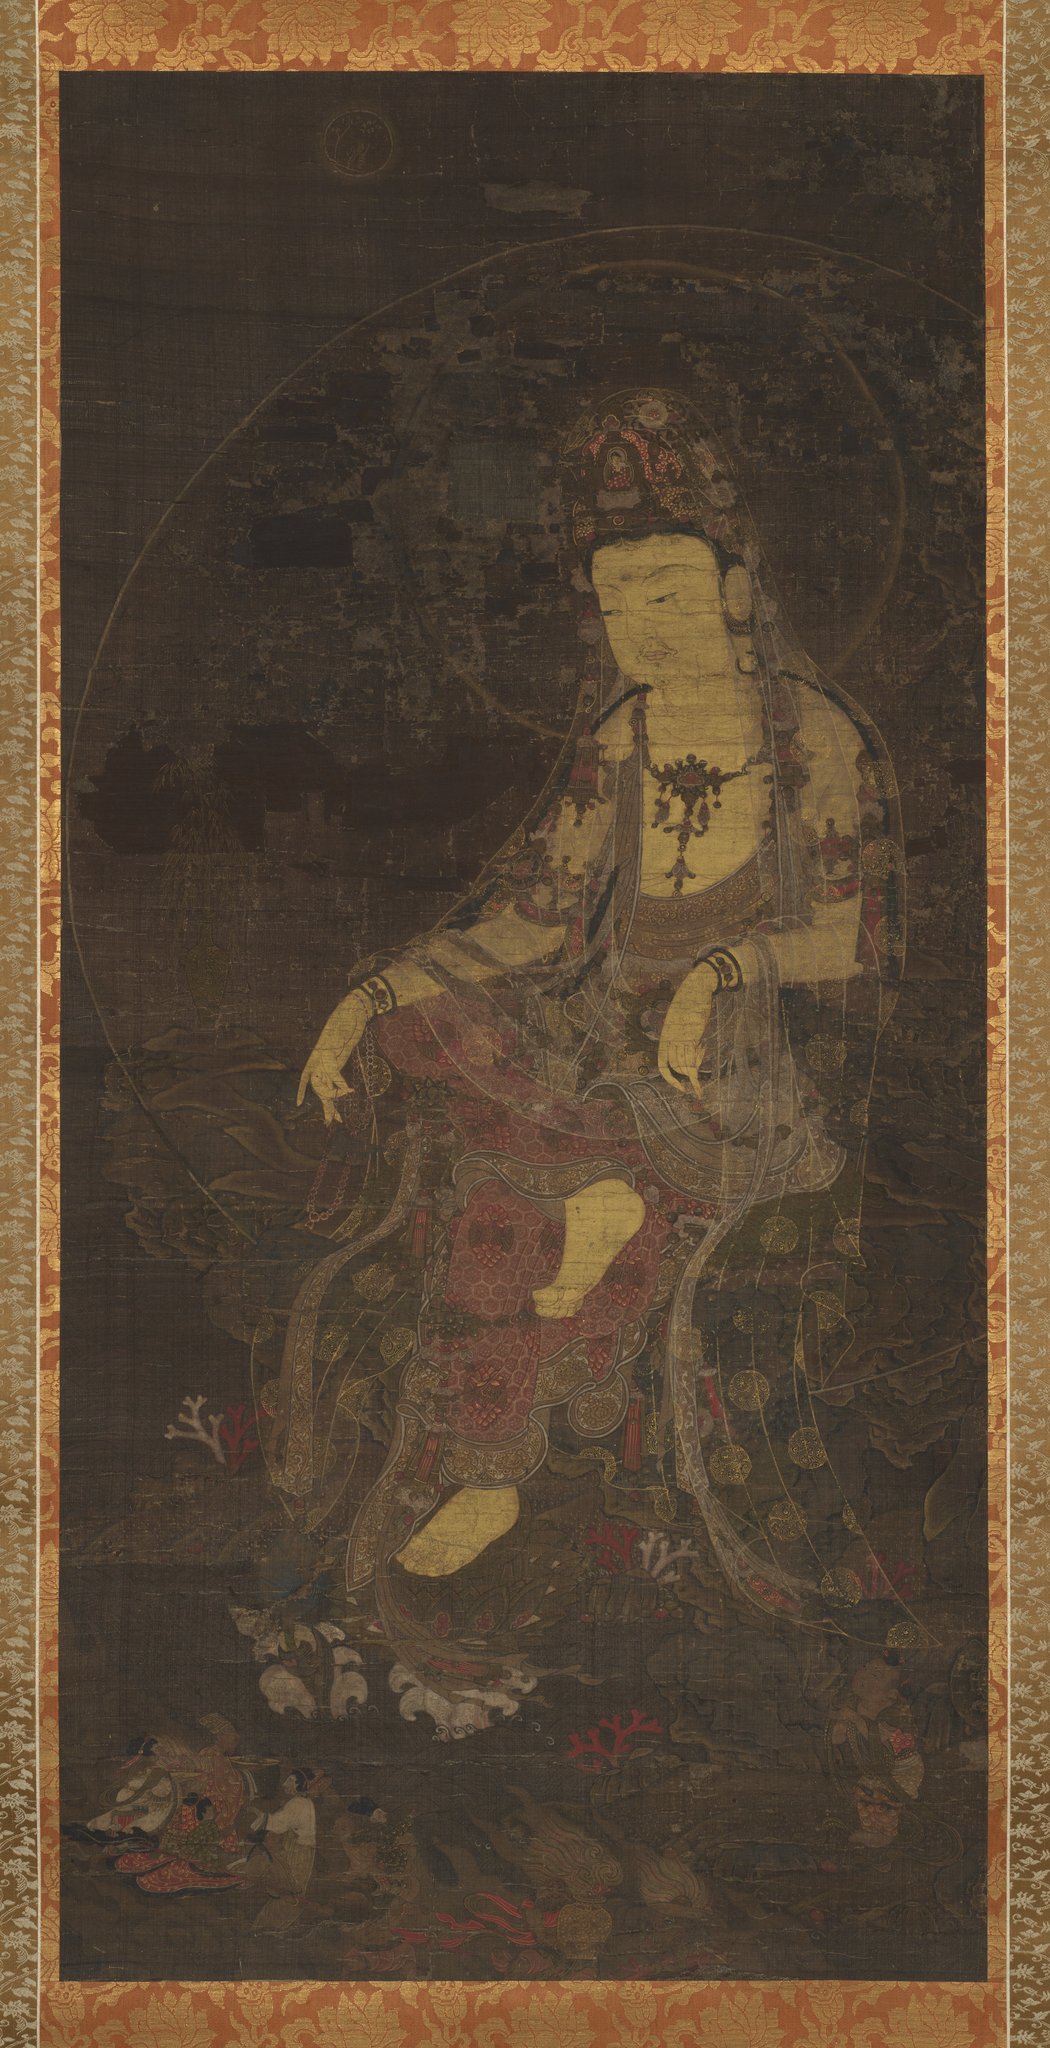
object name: hanging scroll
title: Water-moon Avalokiteshvara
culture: korean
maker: unidentified artist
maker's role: artist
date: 1301-1350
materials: ink, silk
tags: buddhism,avalokiteshvara,bodhisattvas